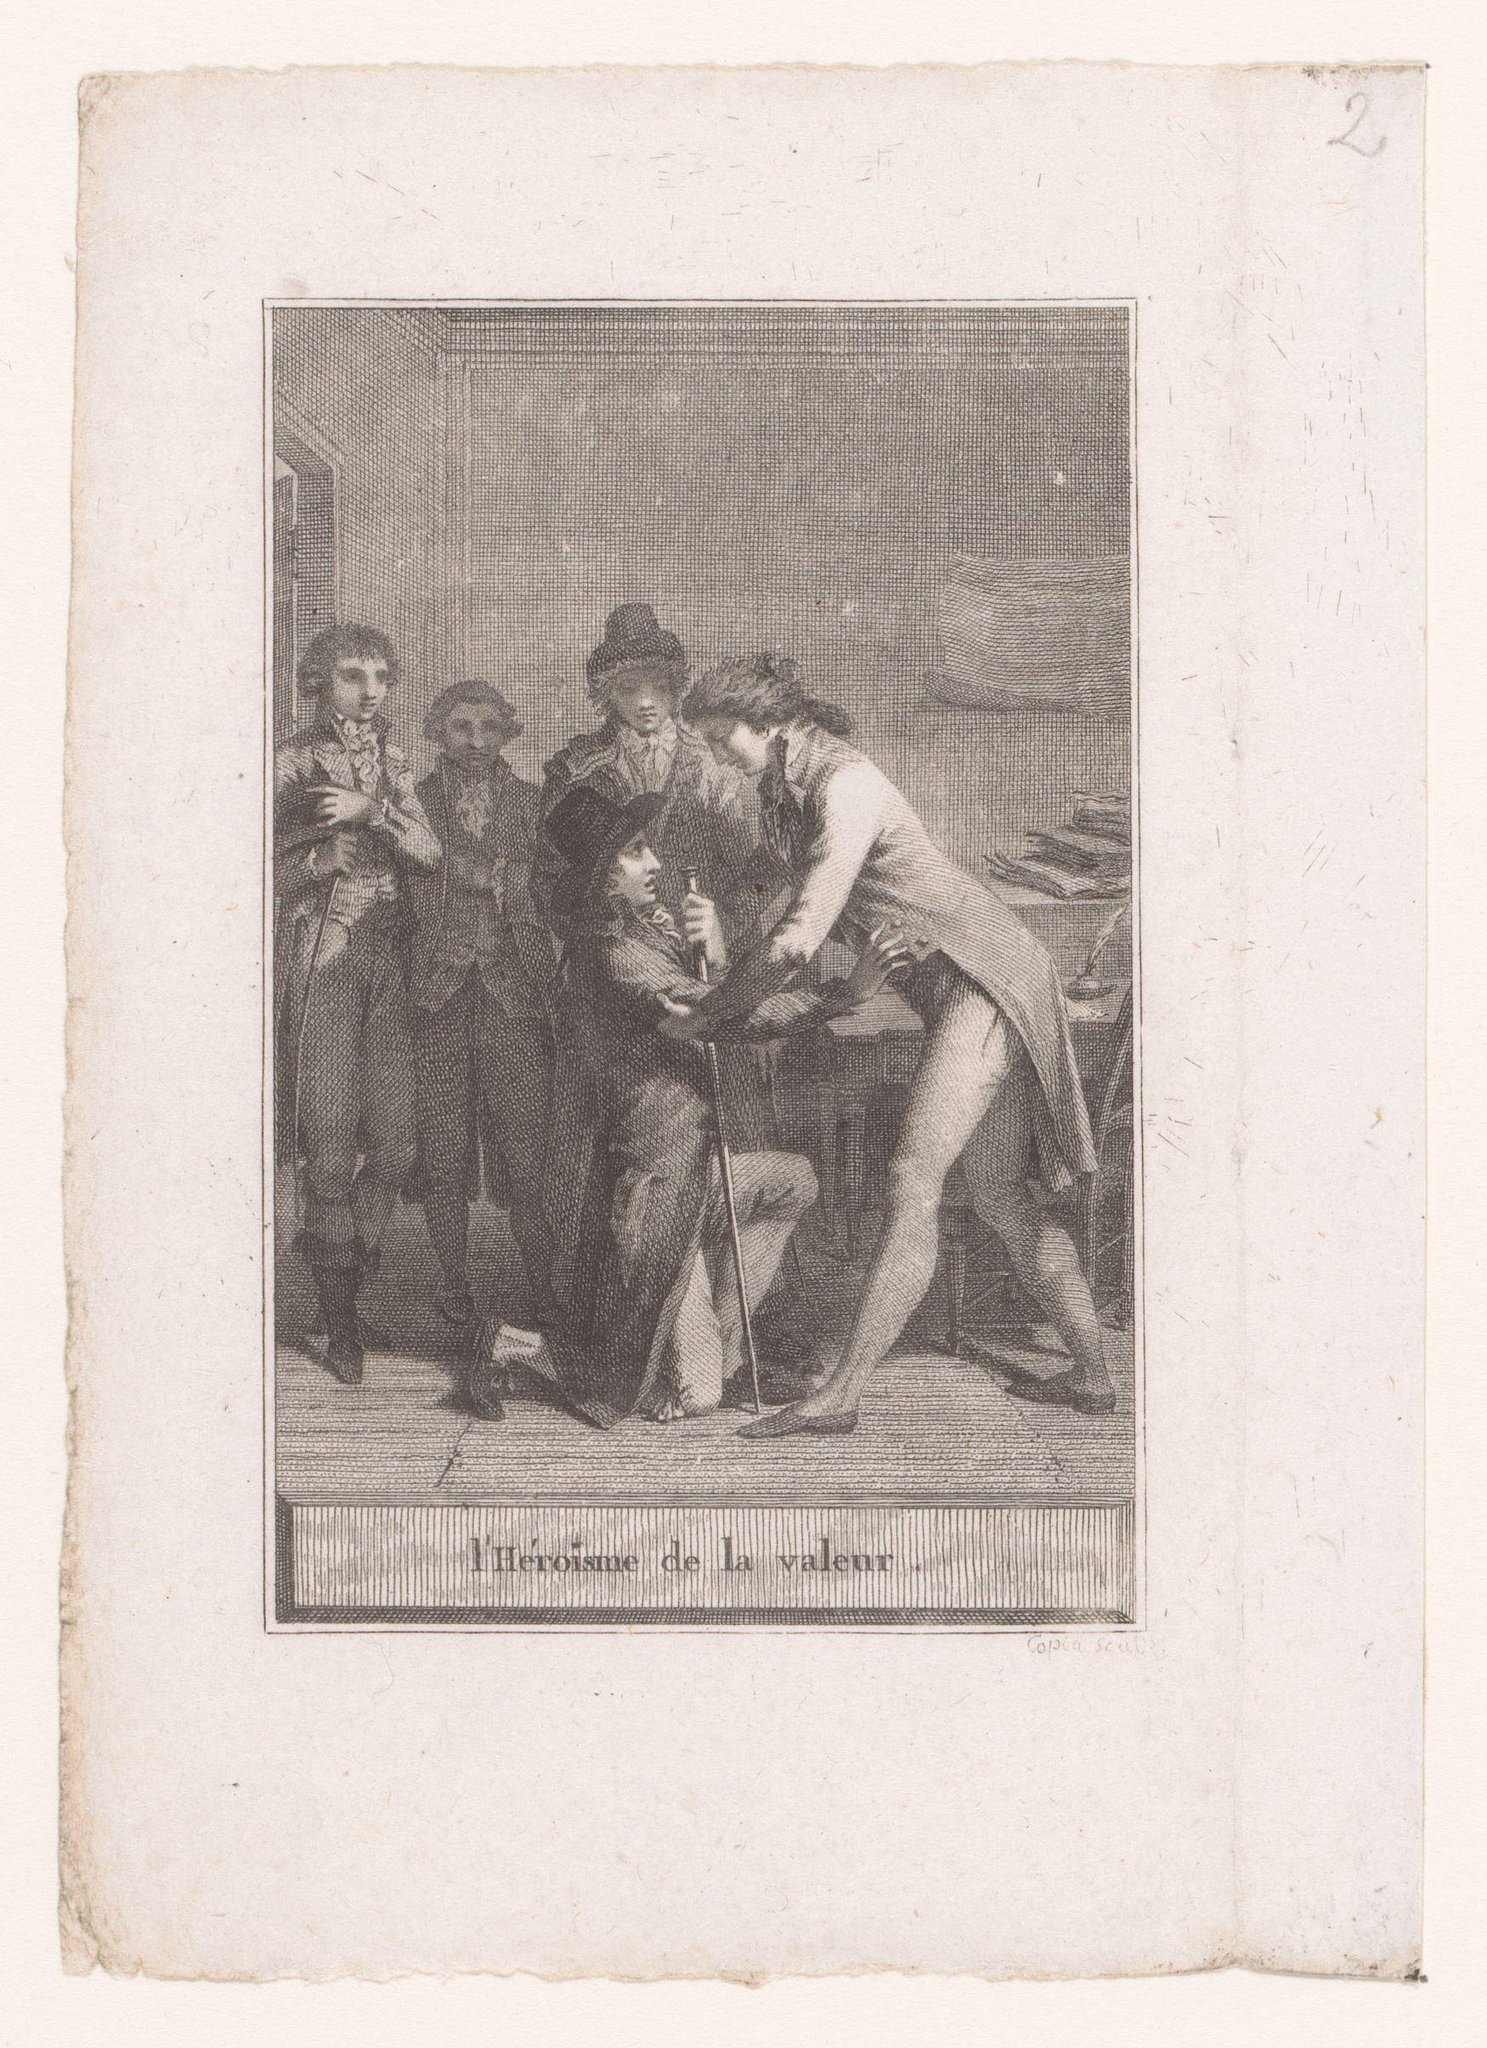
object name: print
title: Milord Edouard en Saint-Preux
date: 1808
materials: paper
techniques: engraving, etching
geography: paris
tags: literary characters and objects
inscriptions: collector's mark: Lugt 2228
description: Prent uit: Rousseau, Jean-Jacques. La nouvelle Heloïse (...). Parijs: Bossange, Masson & Besson e.a., 1808.